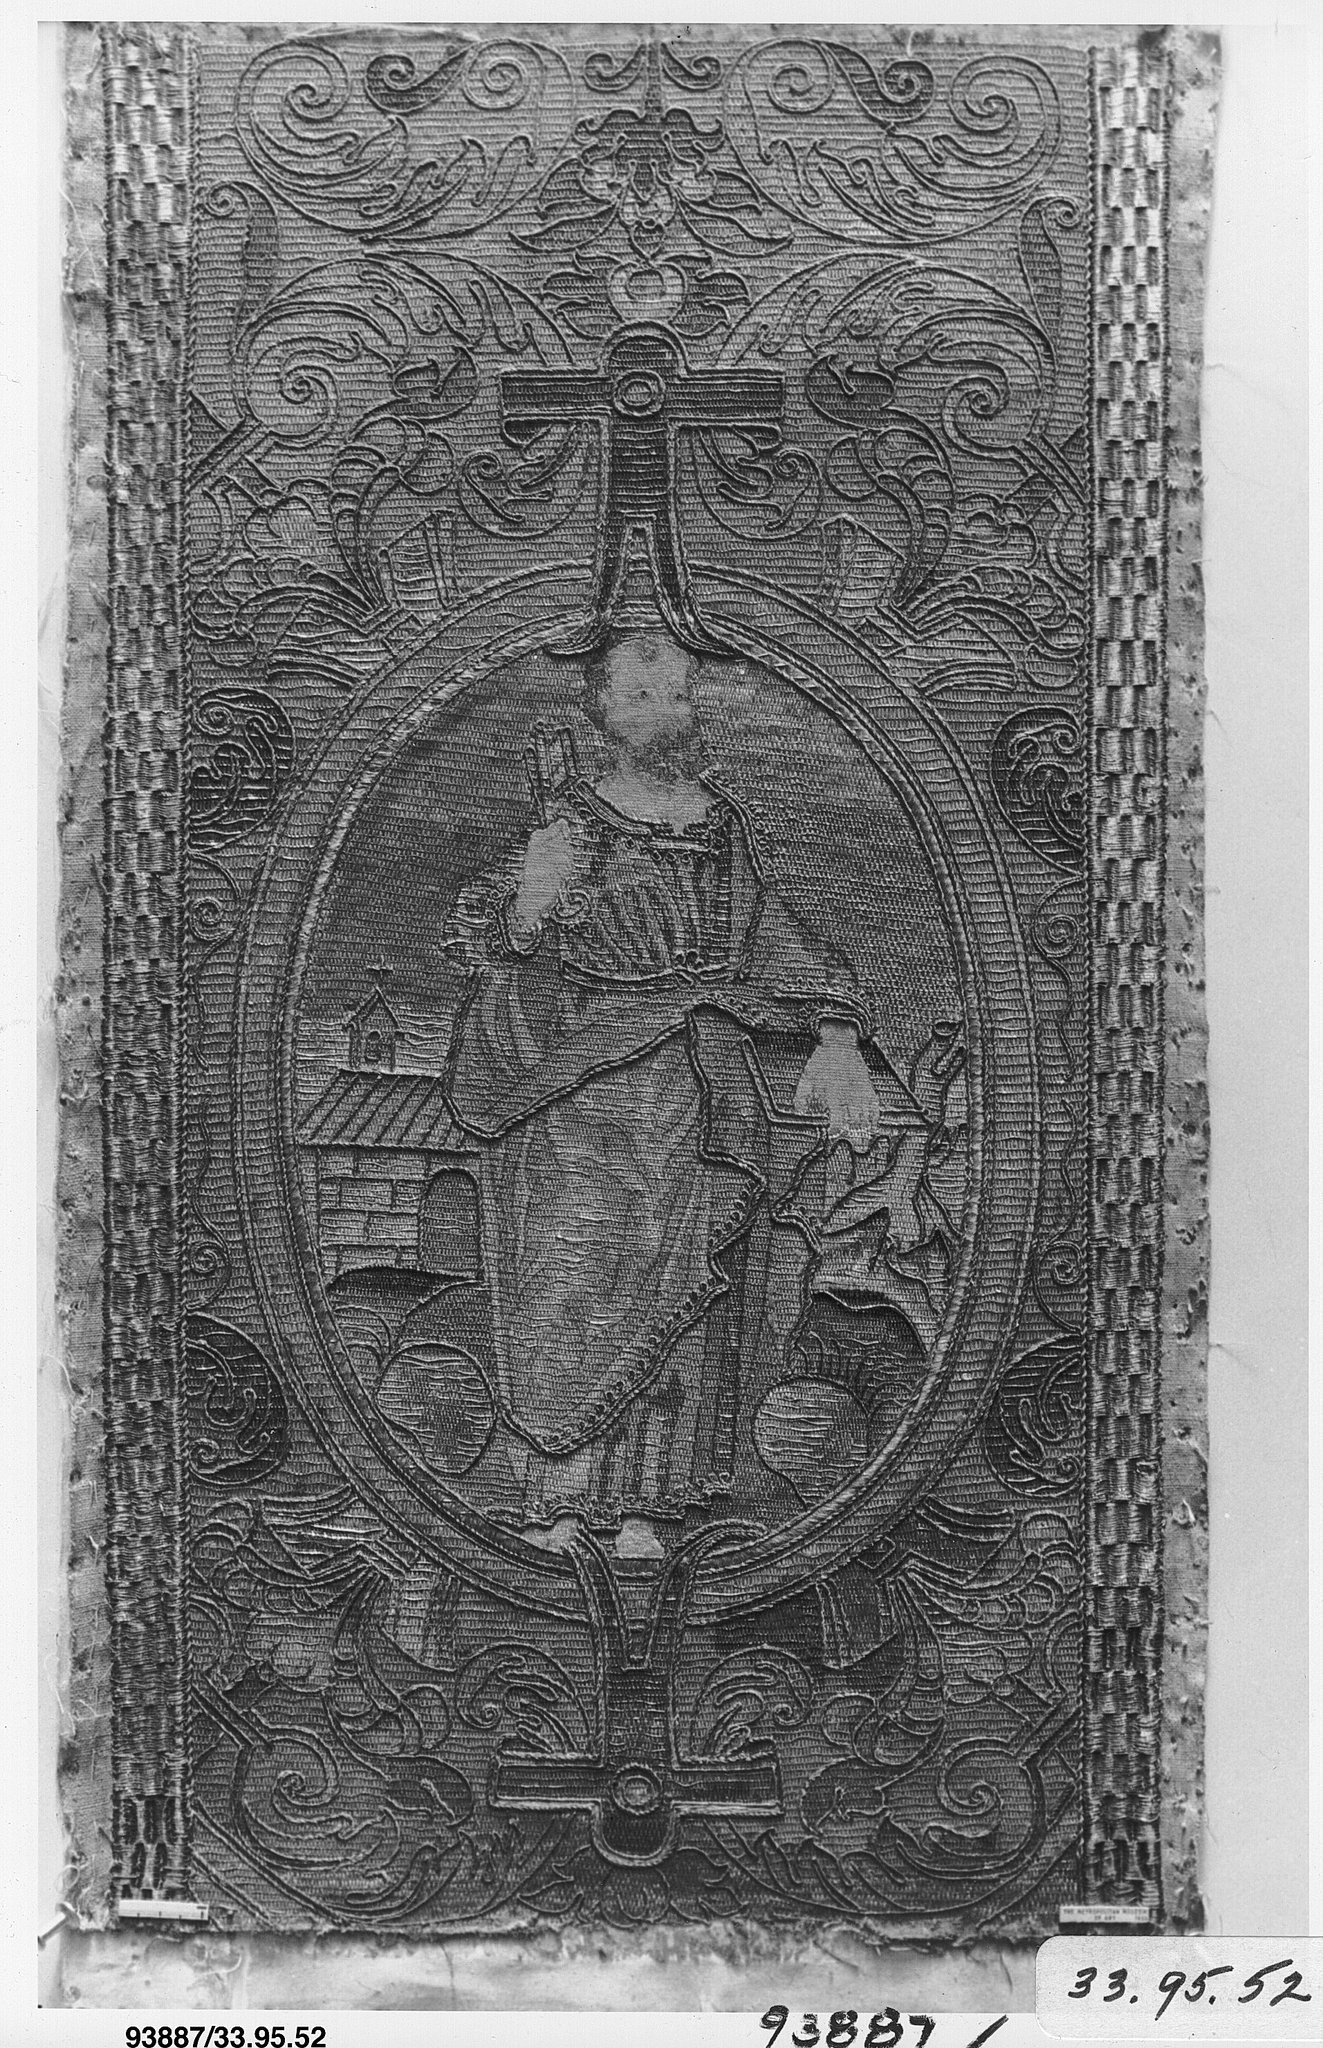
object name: orphrey fragment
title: Fragment of orphrey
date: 1501-1600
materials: linen, metal thread, silk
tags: men